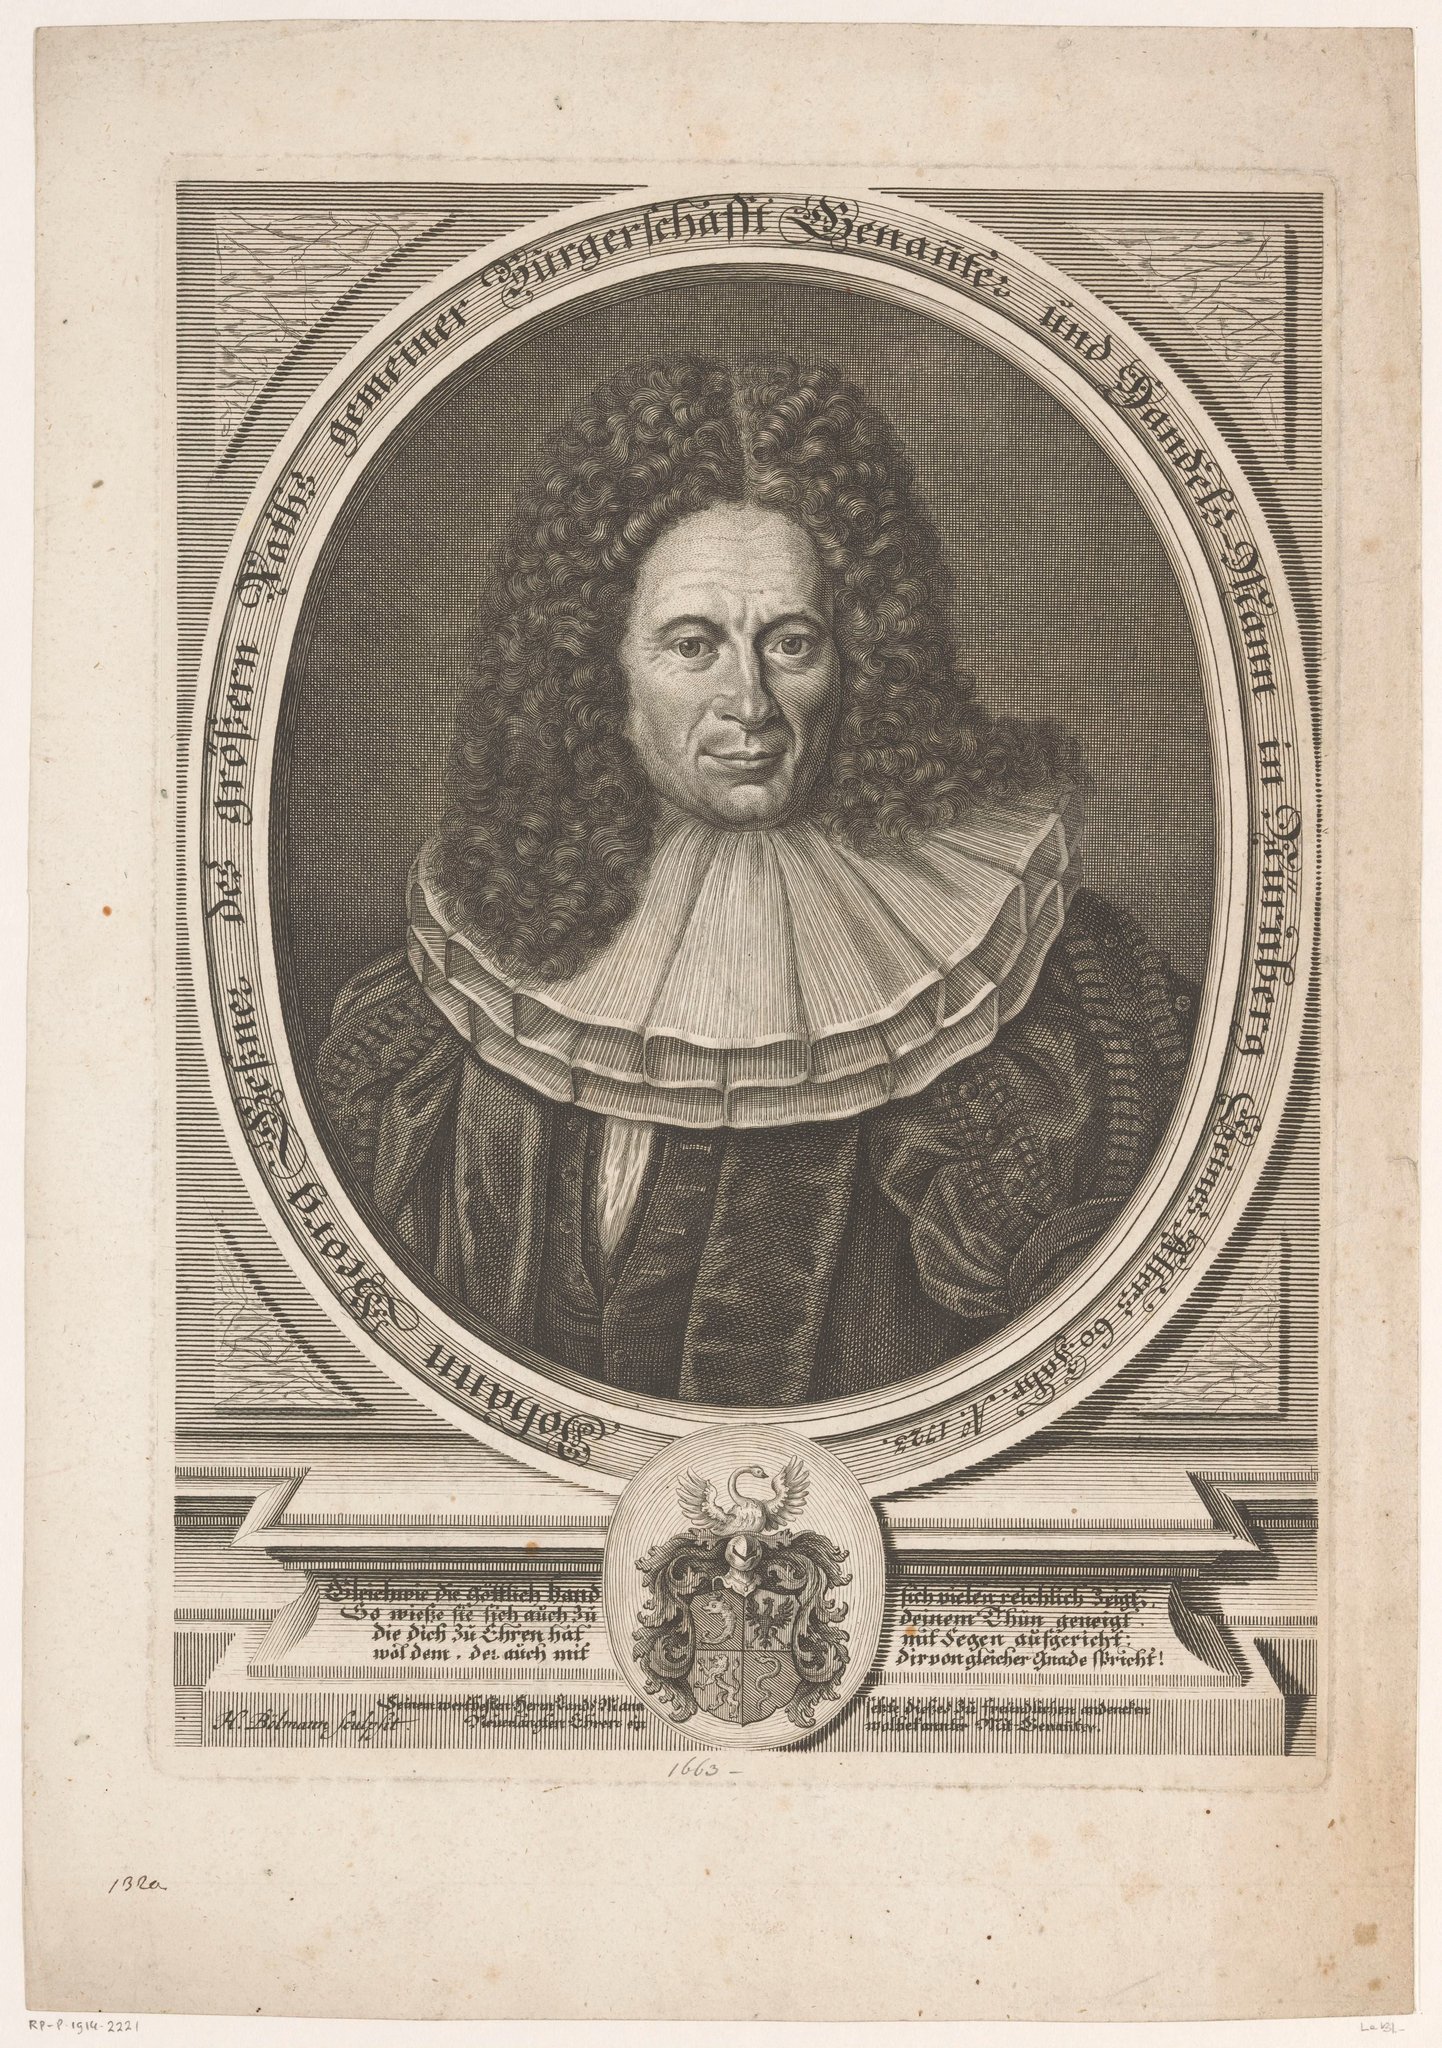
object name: print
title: Portret van Johann Georg Gessner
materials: paper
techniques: engraving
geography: nuremberg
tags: johann georg gessner, historical persons, armorial bearing, heraldry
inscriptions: collector's mark: Lugt 2228